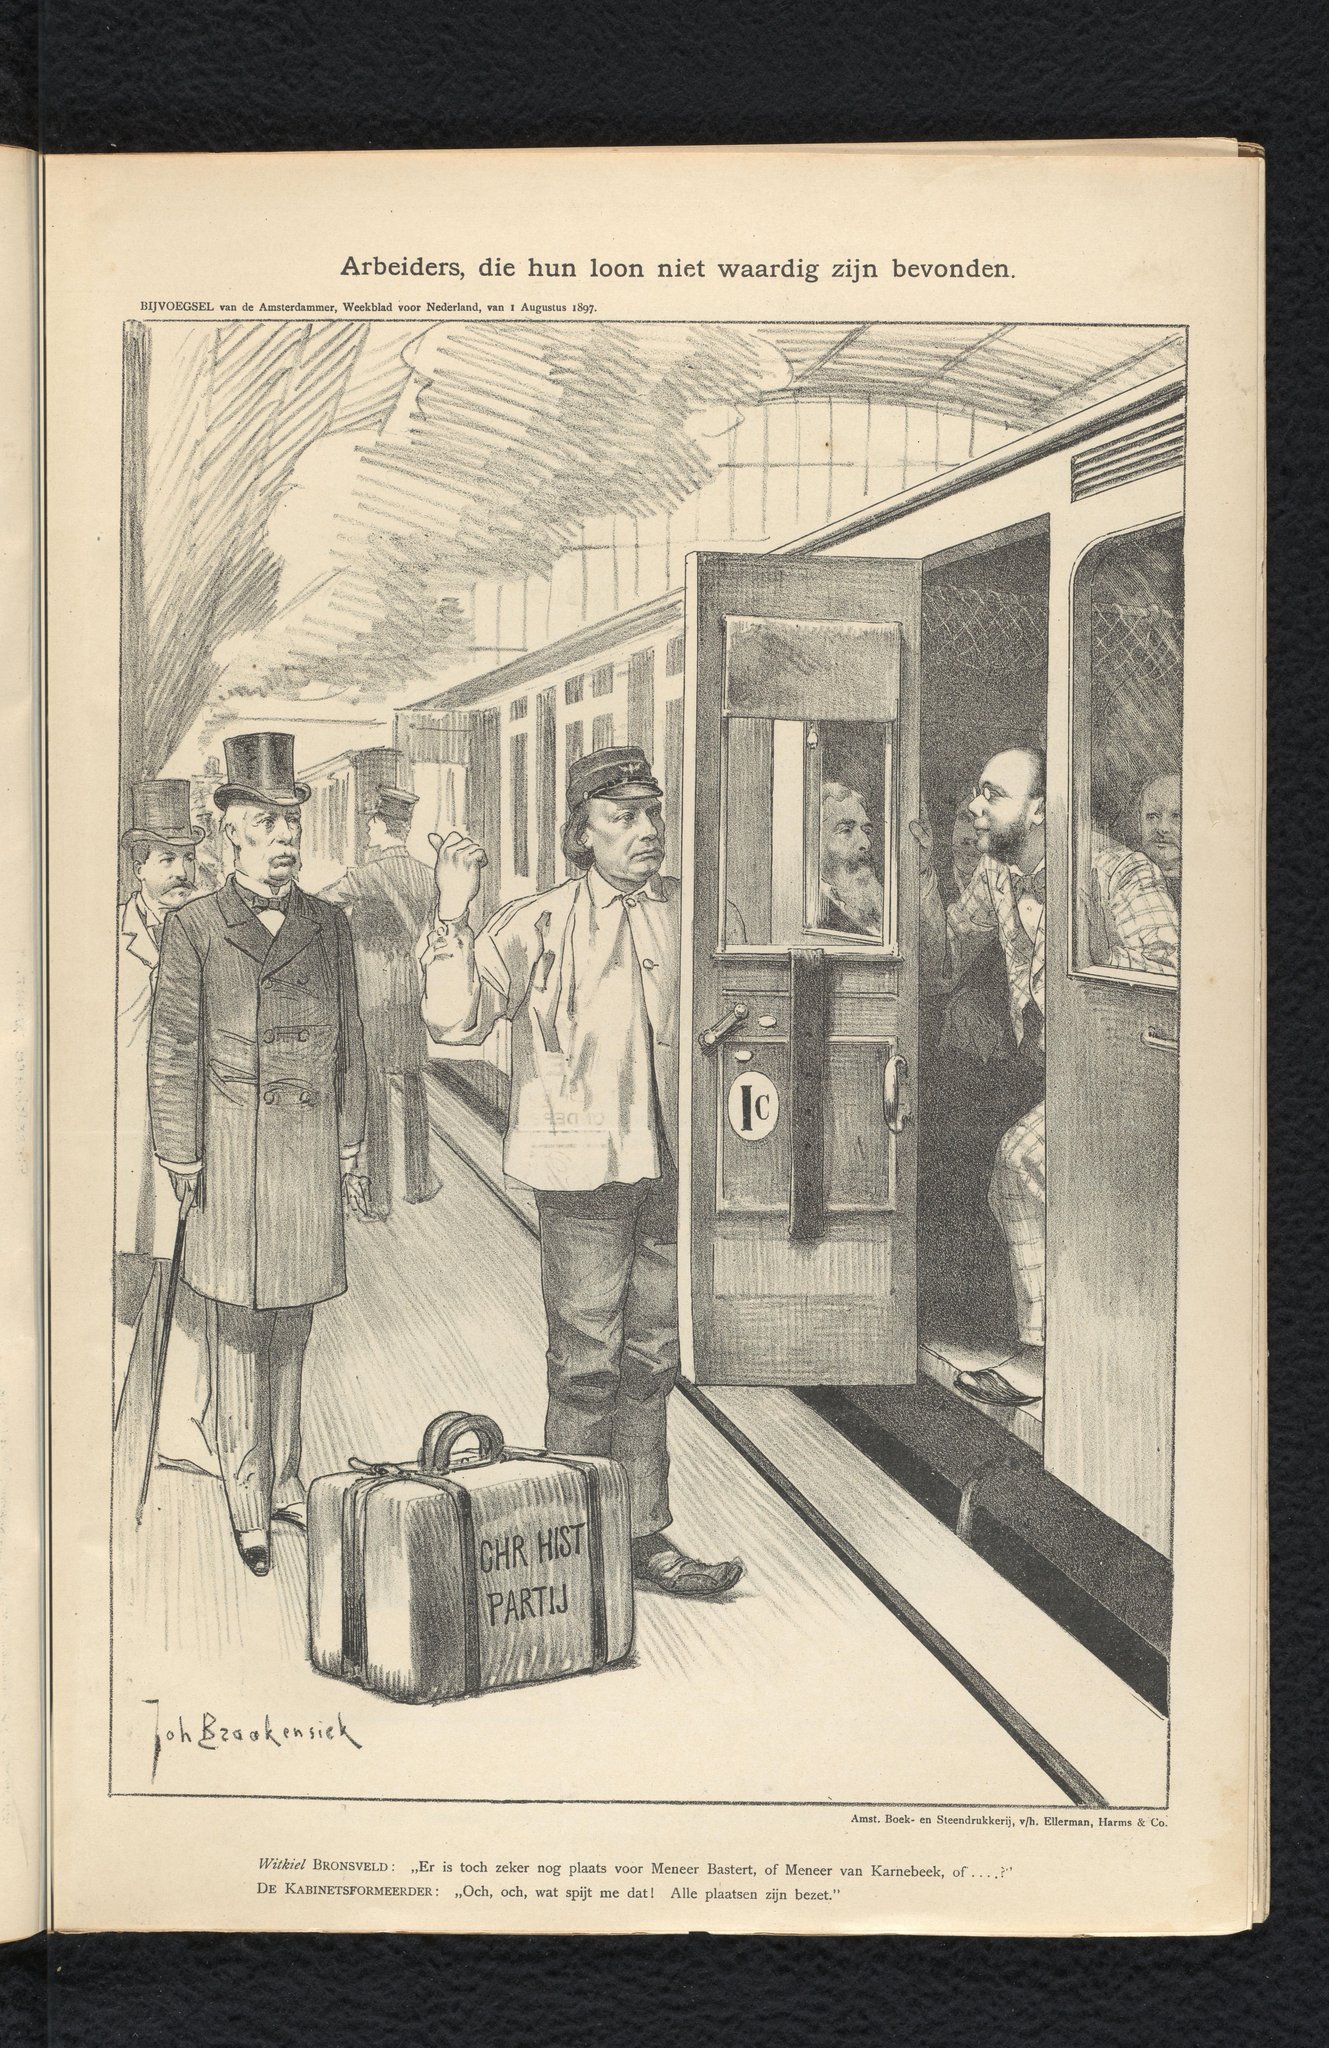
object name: cartoon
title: Arbeiders, die hun loon niet waardig zijn bevonden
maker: johan braakensiek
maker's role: draughtsman, print maker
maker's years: 1858-1940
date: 1897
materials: paper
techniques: lithograph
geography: amsterdam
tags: amsterdam, politician, nicolaas gerard pierson, utrecht, railway-traffic, voting, election, platform (railway, tramway), station; shelter (railway, tramway), porter, bearer, political caricatures and satires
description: Ds. Bronsveld als portier op het perron vraagt aan formateur Pierson of er nog plaats is voor één van de twee heren van zijn partij. Pierson geeft echter aan dat alle plaatsen in de coupé (kabinet) al bezet zijn.